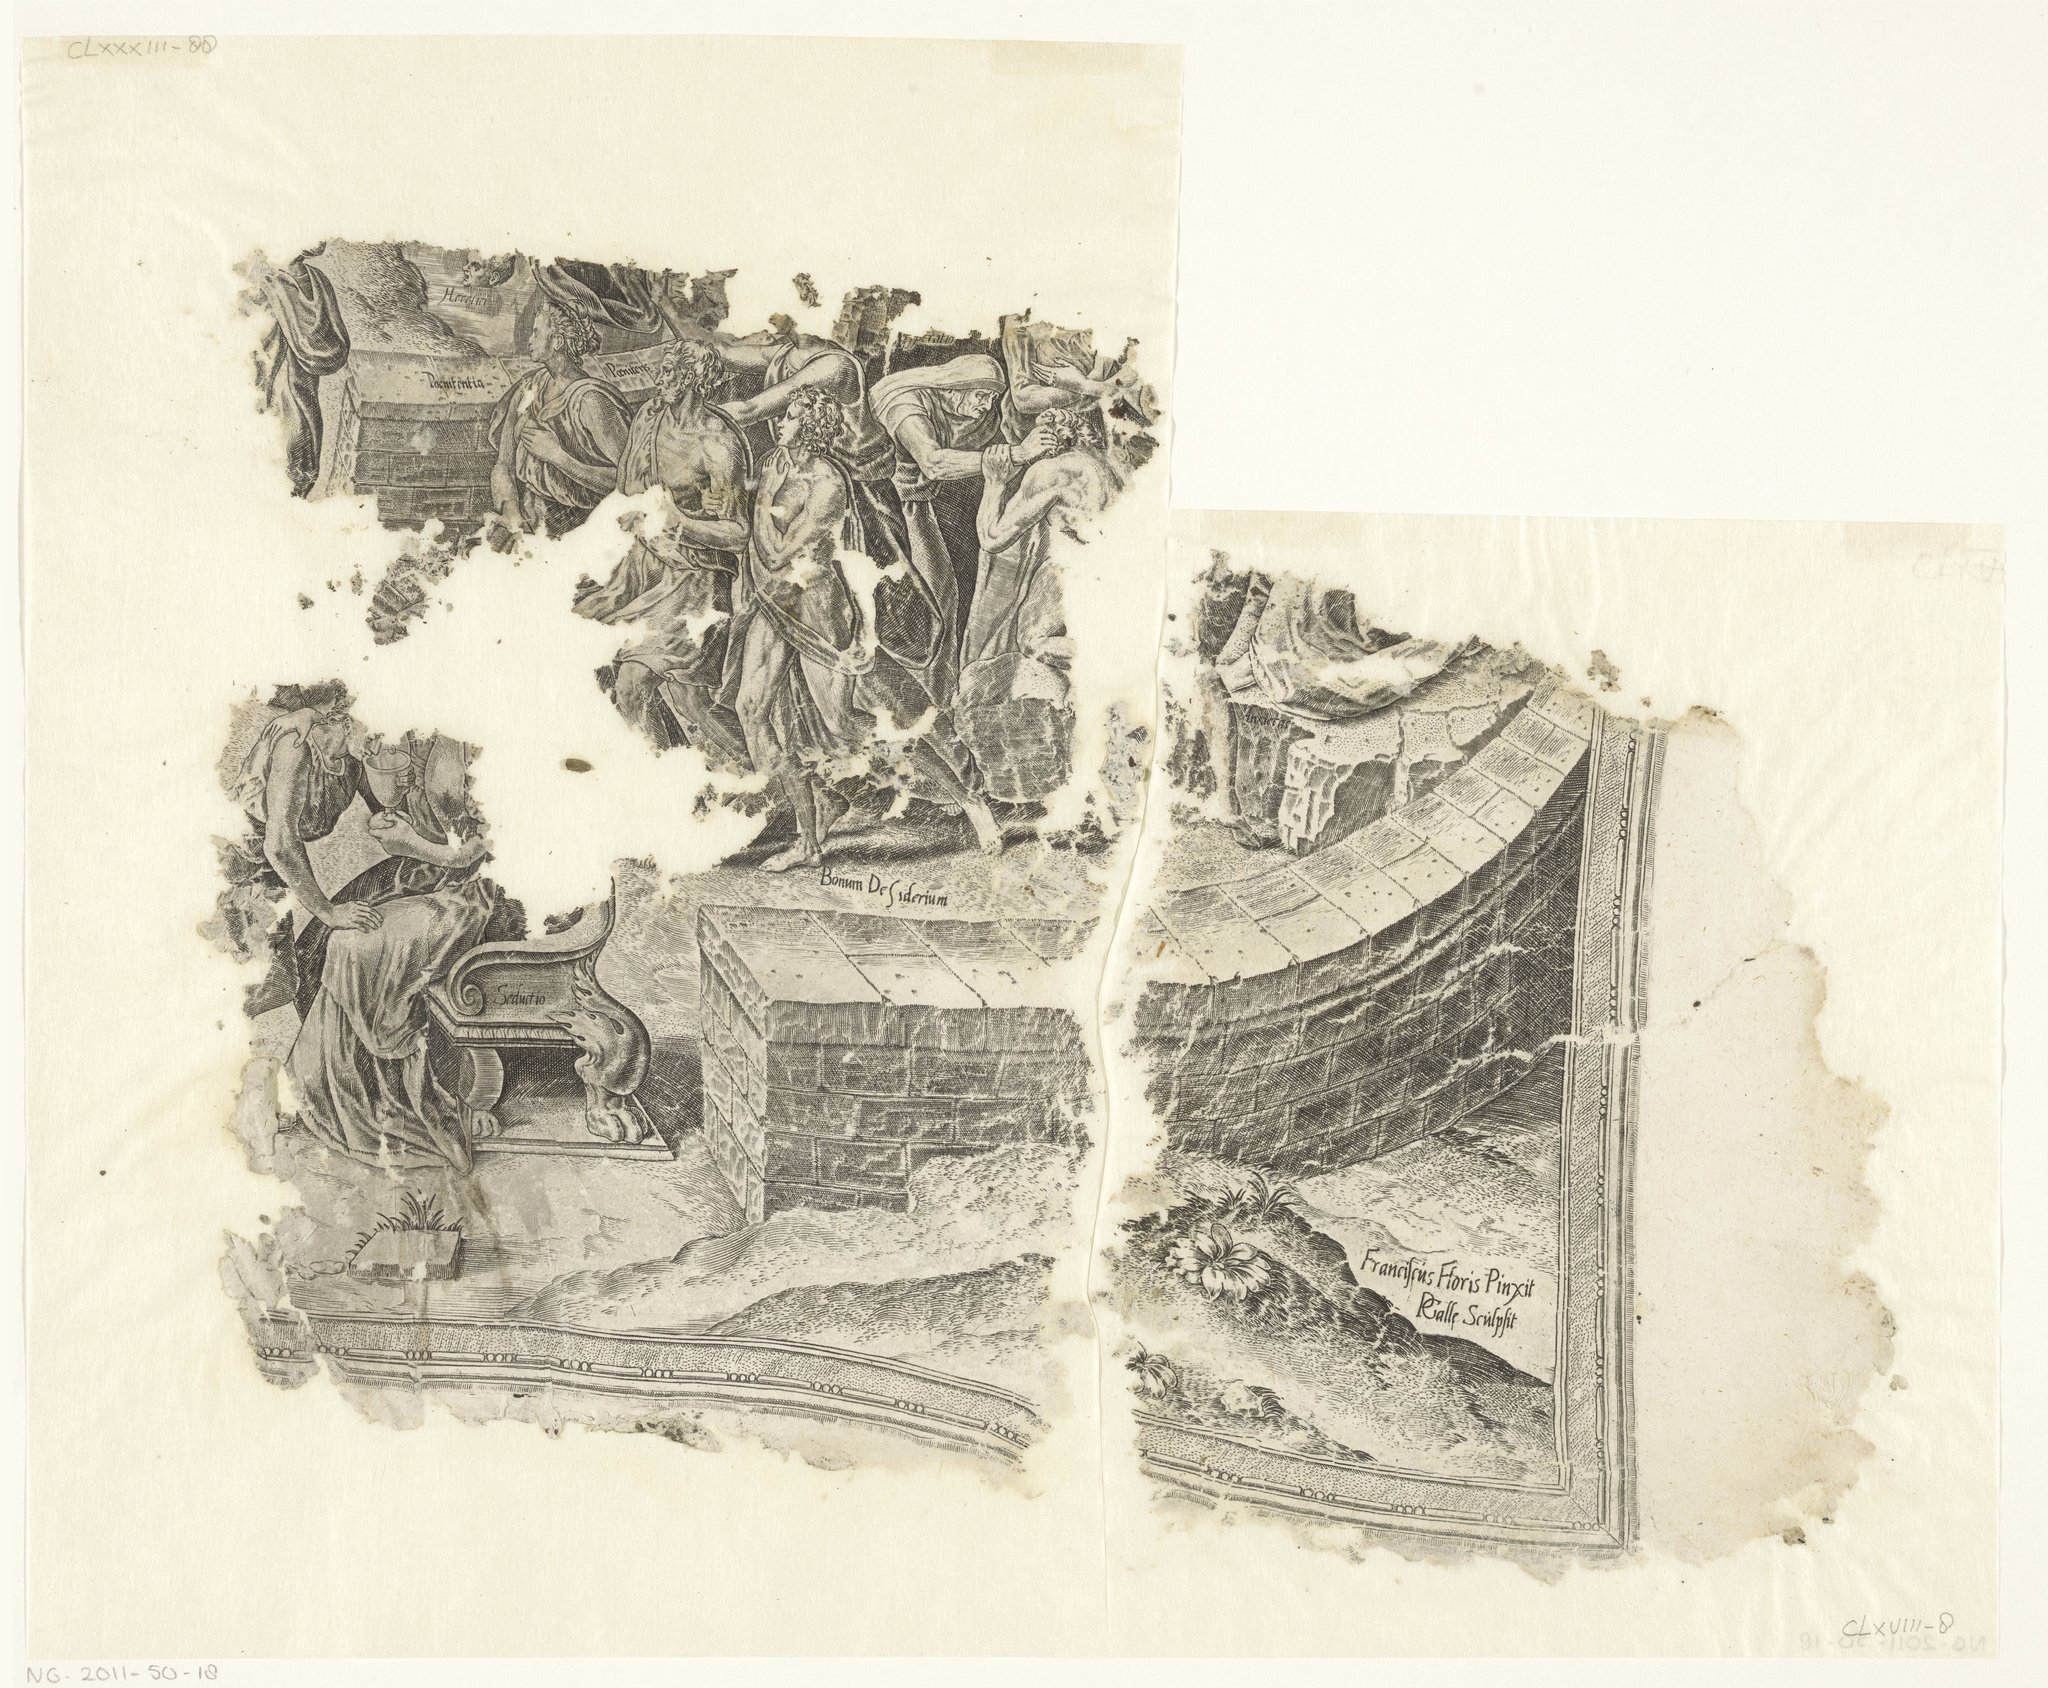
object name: print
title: Tabula Cebetis Carta Vitae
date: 1561-1596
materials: paper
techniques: engraving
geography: southern netherlands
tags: 'tabula cebetis'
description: Allegorie over de heilsweg van de mens. Het leven als een stad met drie ommuurde terreinen, met in het midden een tempel. Bij de buitenste poort staan de zielen van kinderen te wachten, klaar om het volwassen leven te betreden. Voor het binnengaan krijgen zij iets te drinken van Verleiding (Seductio), die hen onwetend maakt. Het eerste ommuurde terrein toont allerlei ver- en afleidingen, zoals Vooroordeel (Opinio), Begeerte (Cupiduas), Twijfel (Error) en Onwetendheid (Ignorantia). Zij beletten de jeugdige mens verder door te dringen tot de volgende cirkel. Alleen door de personificaties te volgen van Berouw (Poenitentia), Hoop (Spes) en Goed Verlangen (Bonnem Desiderium) kan de mens toegang krijgen tot de tweede cirkel. Daar krijgt hij onderricht in alle vormen van wereldse kennis. Links staan de zeven artes liberales en rechts debatteren verschillende geleerden. De mens wordt in deze cirkel op de proef gesteld en geconfronteerd met valse kennis (Falsa Disciplina). Met behulp van Zelfbeheersing (Continentia) en Geduldigheid (Tolerantia) kan de berg verder worden beklommen. Het derde ommuurde terrein, ten slotte, wordt bewaakt door Waarheid (Veritas). Zij verleent de mens toegang tot het ware geluk. Hij wordt er verwelkomd door de kardinale deugden en mag verblijven in het huis van de gelukzaligen, waar het ware geluk op hem wacht. Gereconstrueerd uit twee fragmenten.